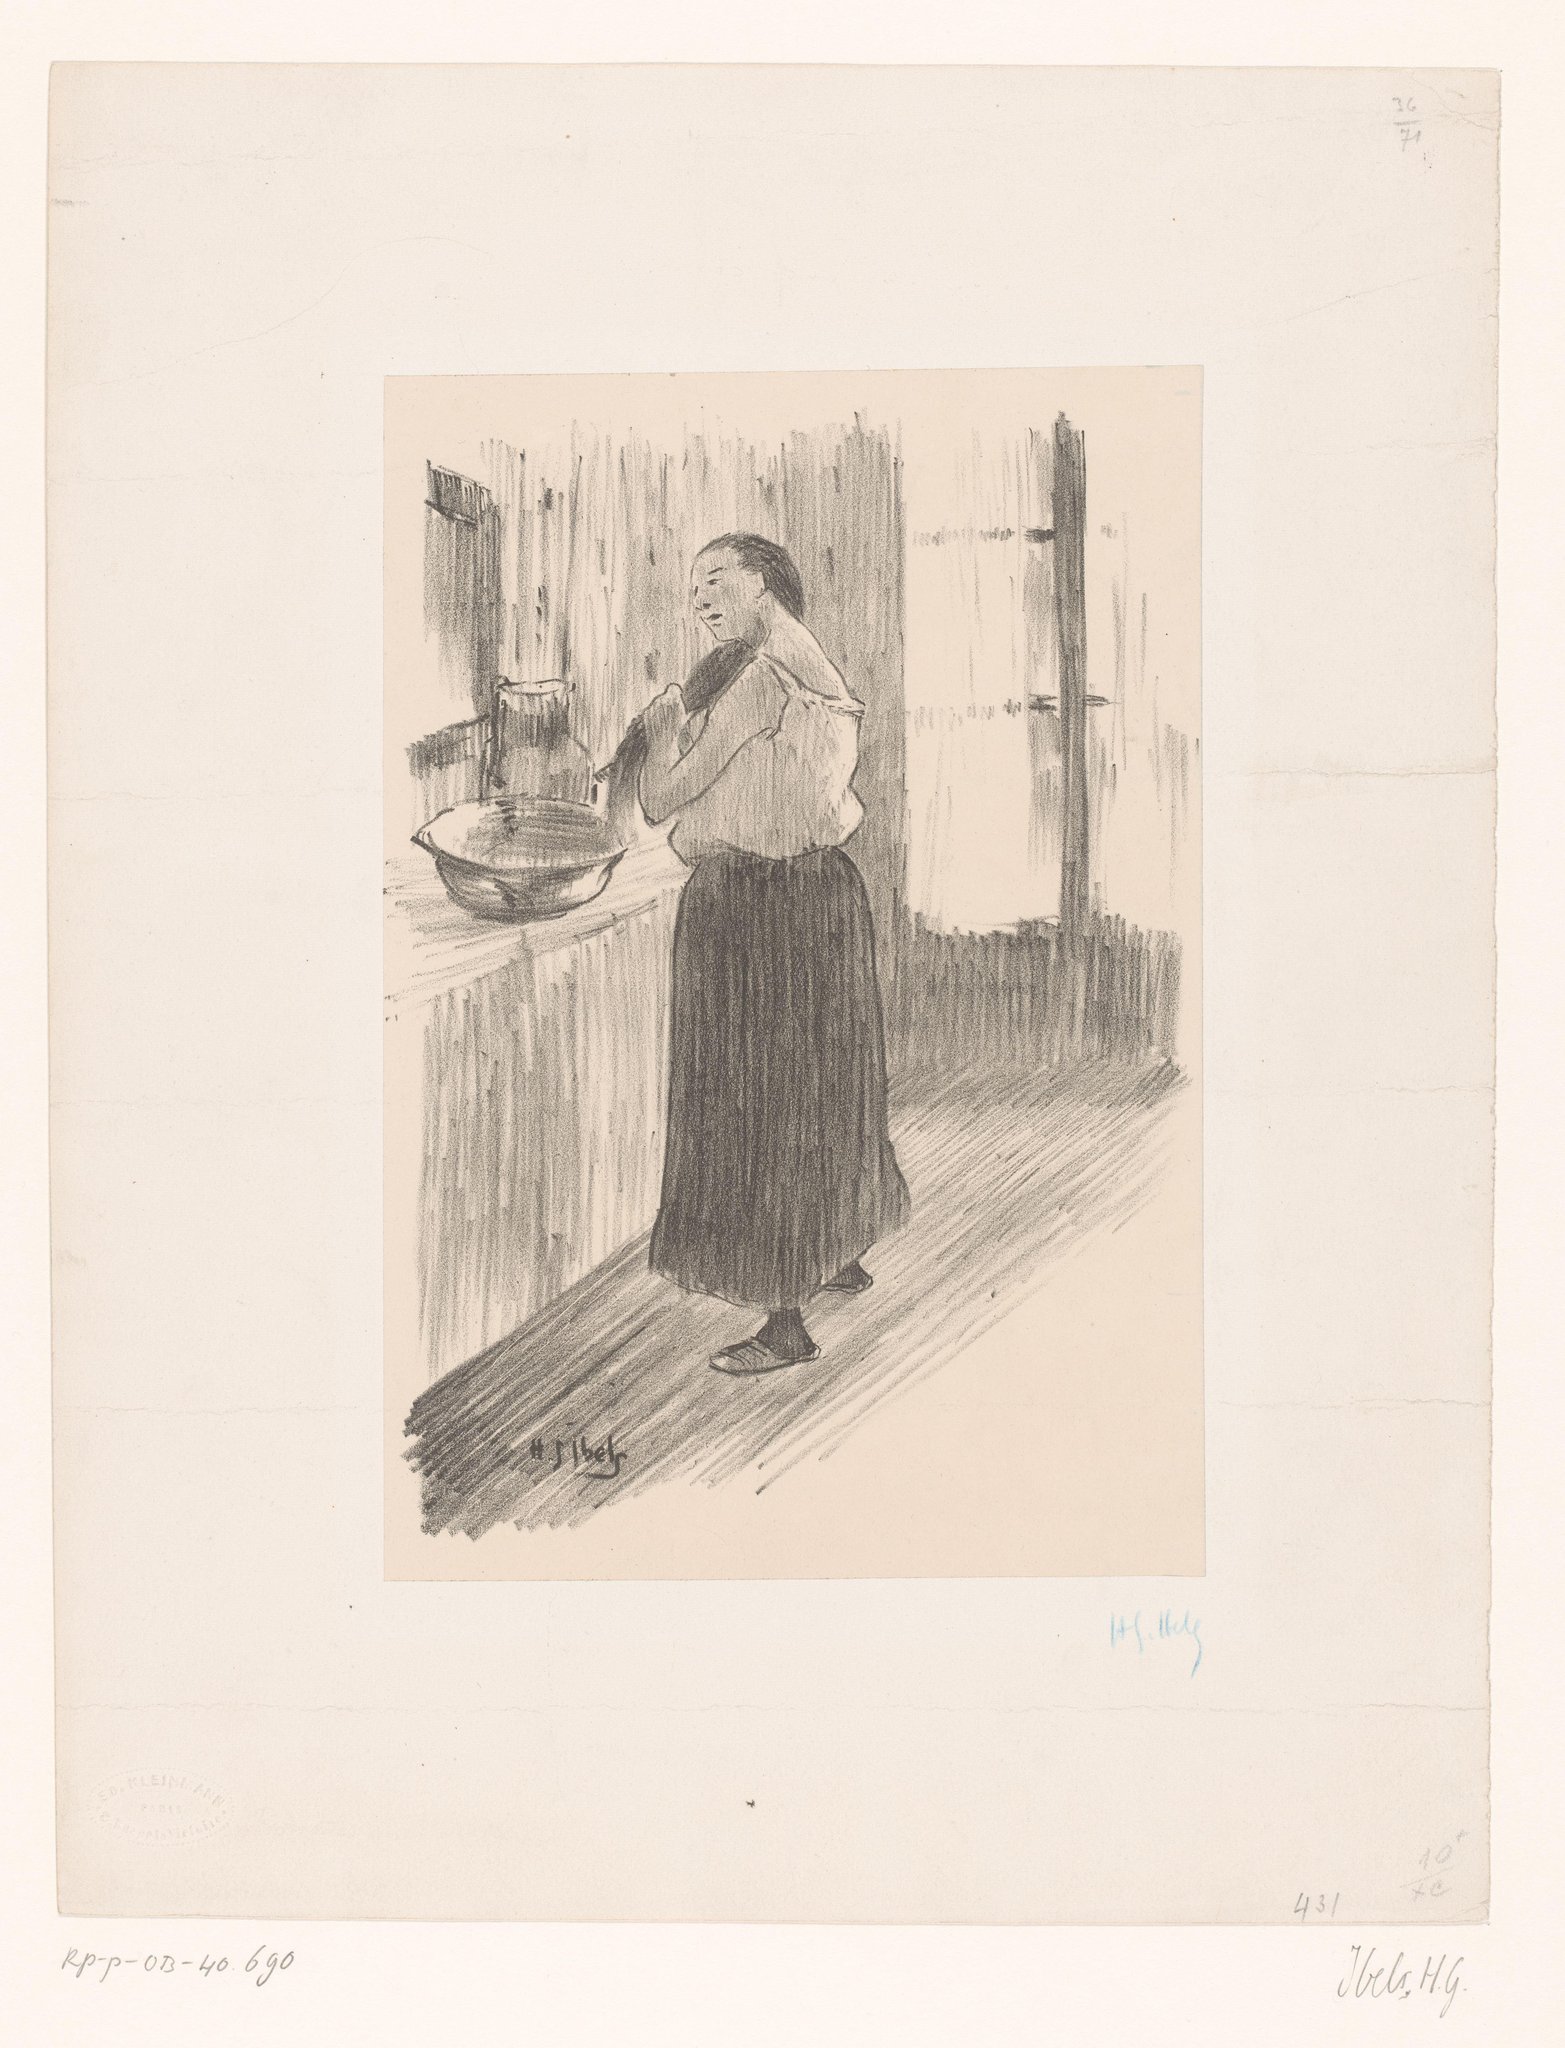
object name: print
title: Vrouw kamt het haar voor de spiegel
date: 1893-1900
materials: paper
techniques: lithography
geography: paris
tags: comb, brush and other tools (care of the hair) - aa - ~ women, mirror - aa - (for) women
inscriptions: check stamp: Lugt 1573